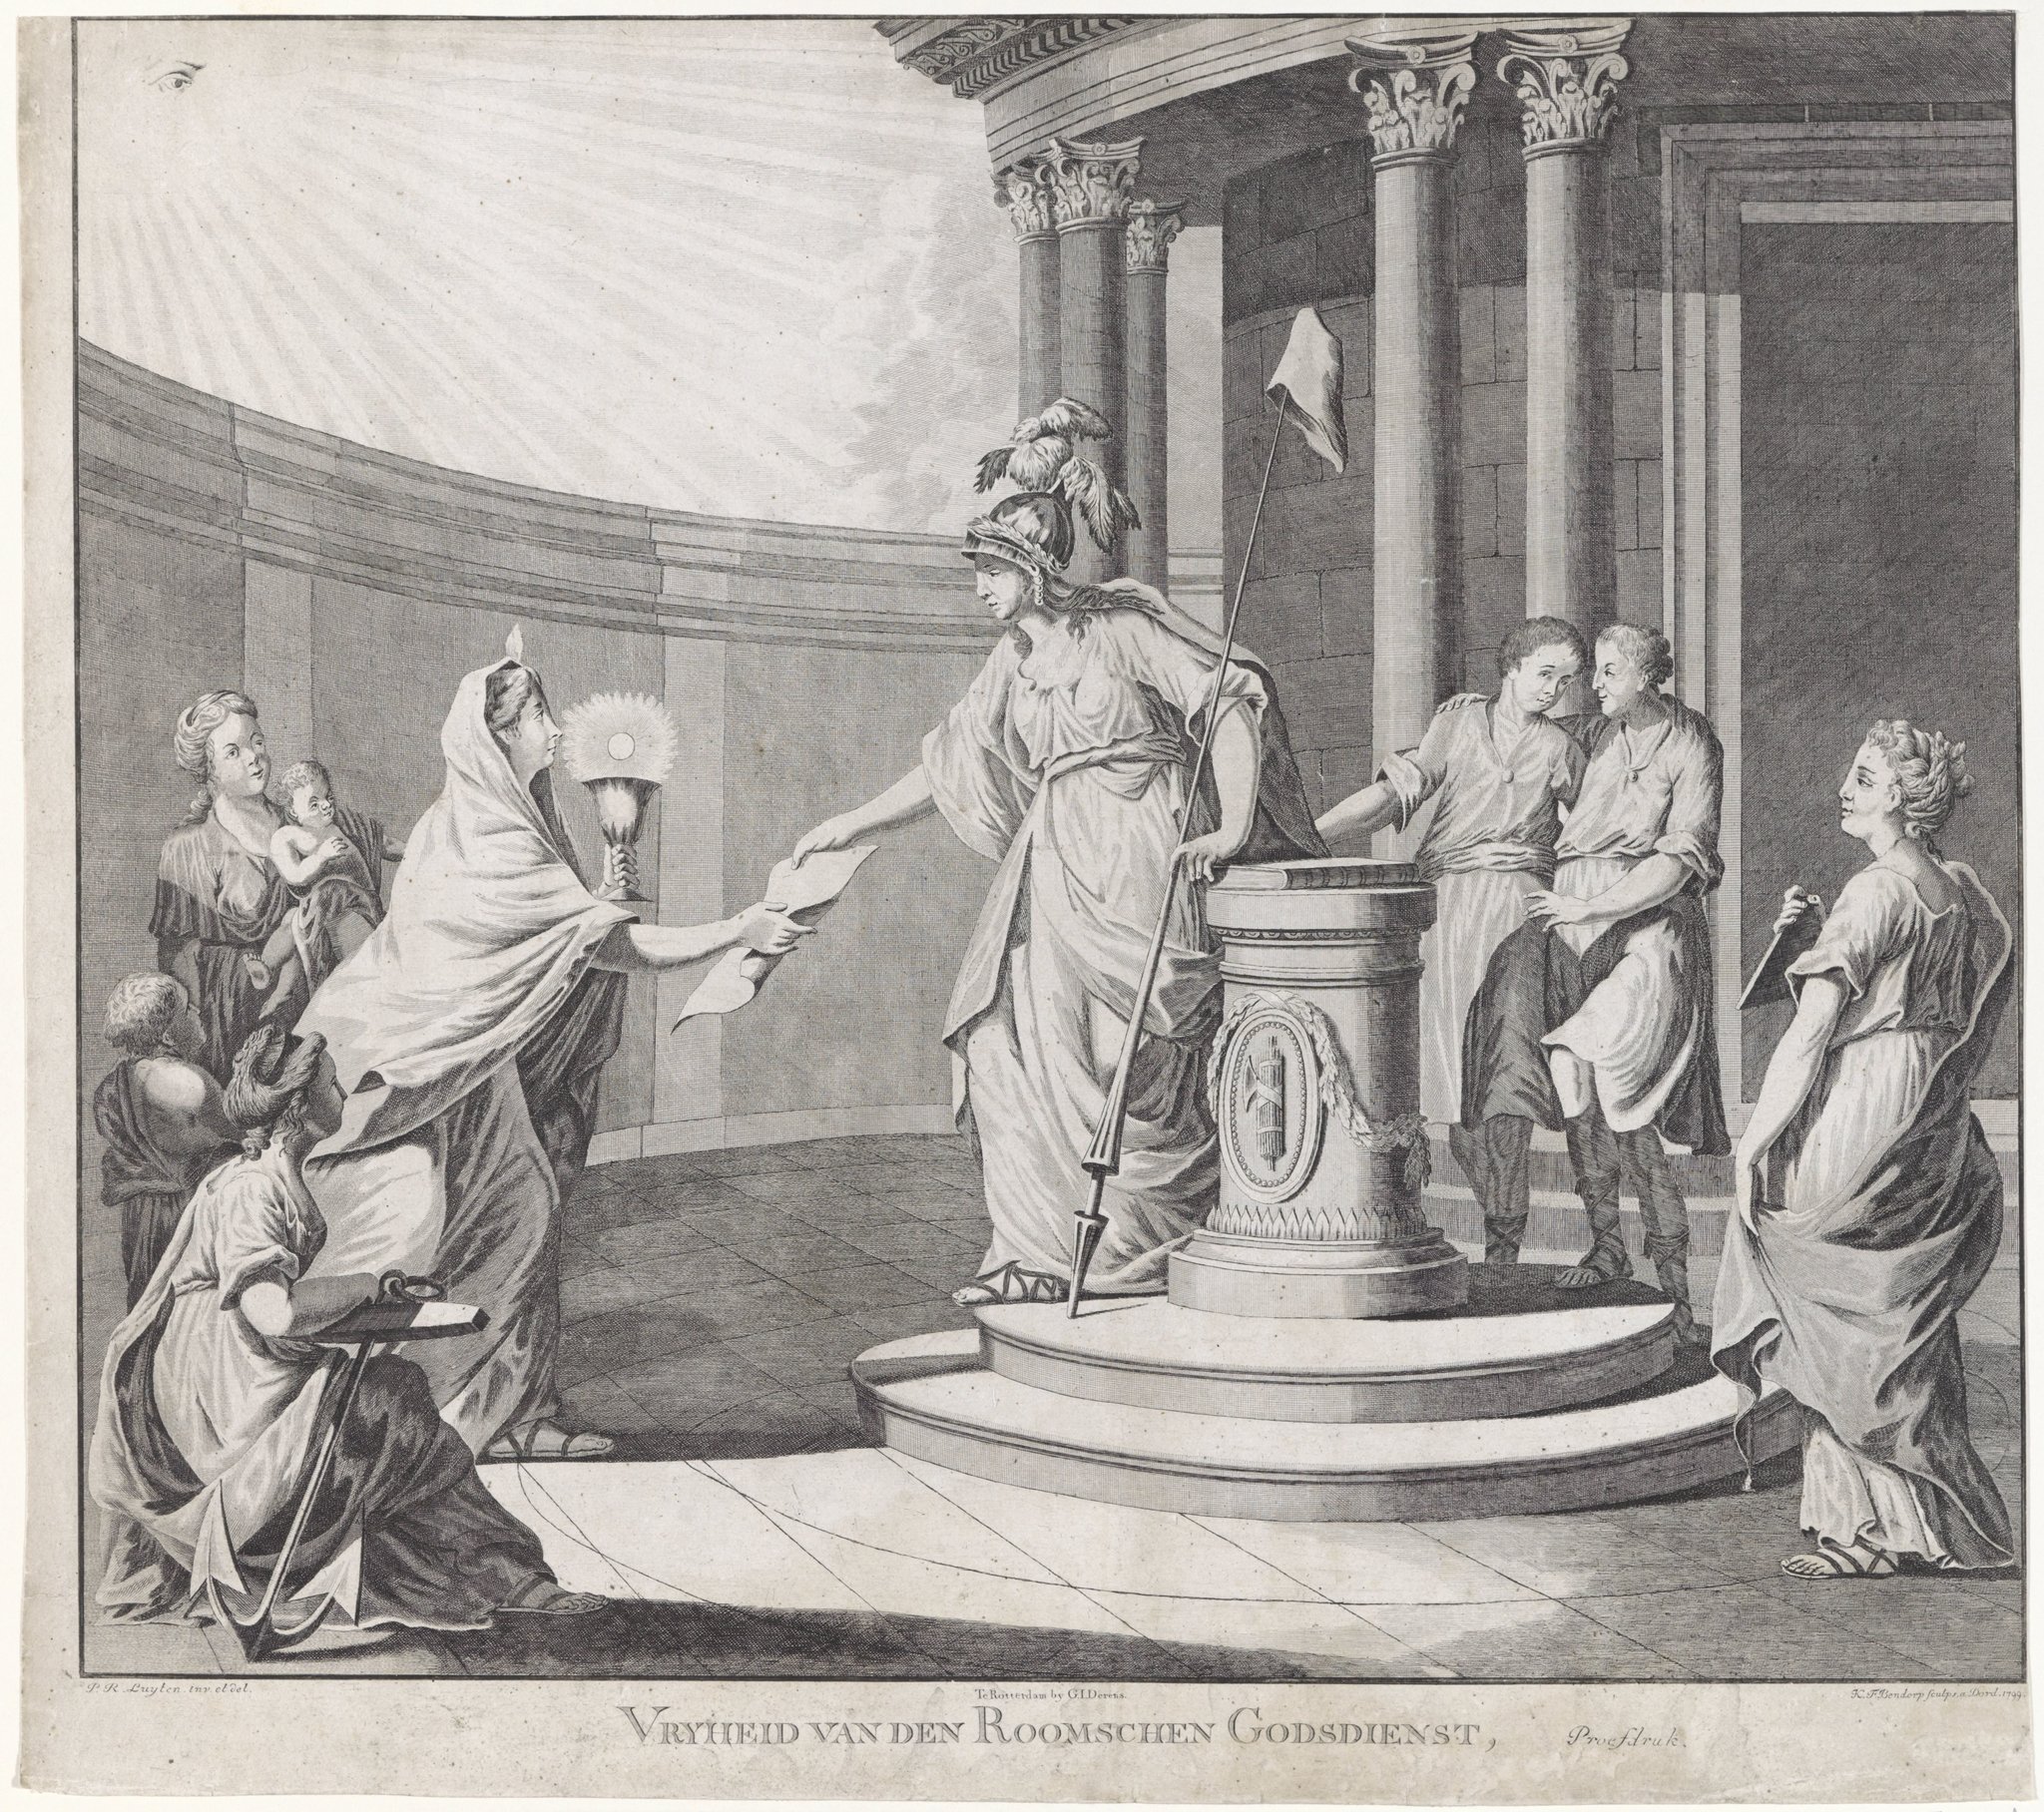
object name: print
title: Allegorie op het gelijkstellen van de rooms-katholieke godsdienst met andere gezindten, 1799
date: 1799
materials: paper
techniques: engraving, etching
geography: dordrecht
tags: equality, equity, fairness, righteousness; 'equalità', 'equità', 'giuditio giusto', 'ordine dritto e giusto', 'ugualità' (ripa) (+ abstract concept represented by female figure), personifications of countries, nations, states, districts, etc., brotherly love (+ two or more personifications pursuing one aim), the three theological virtues, allegorical representations ~ religion; 'religione', 'religione de ss. mauritio e lazaro', 'religione vera christiana' (ripa), netherlands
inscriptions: collector's mark: Lugt 2228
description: Niet in Frederik Muller; door het RPK toegevoegd nummer.